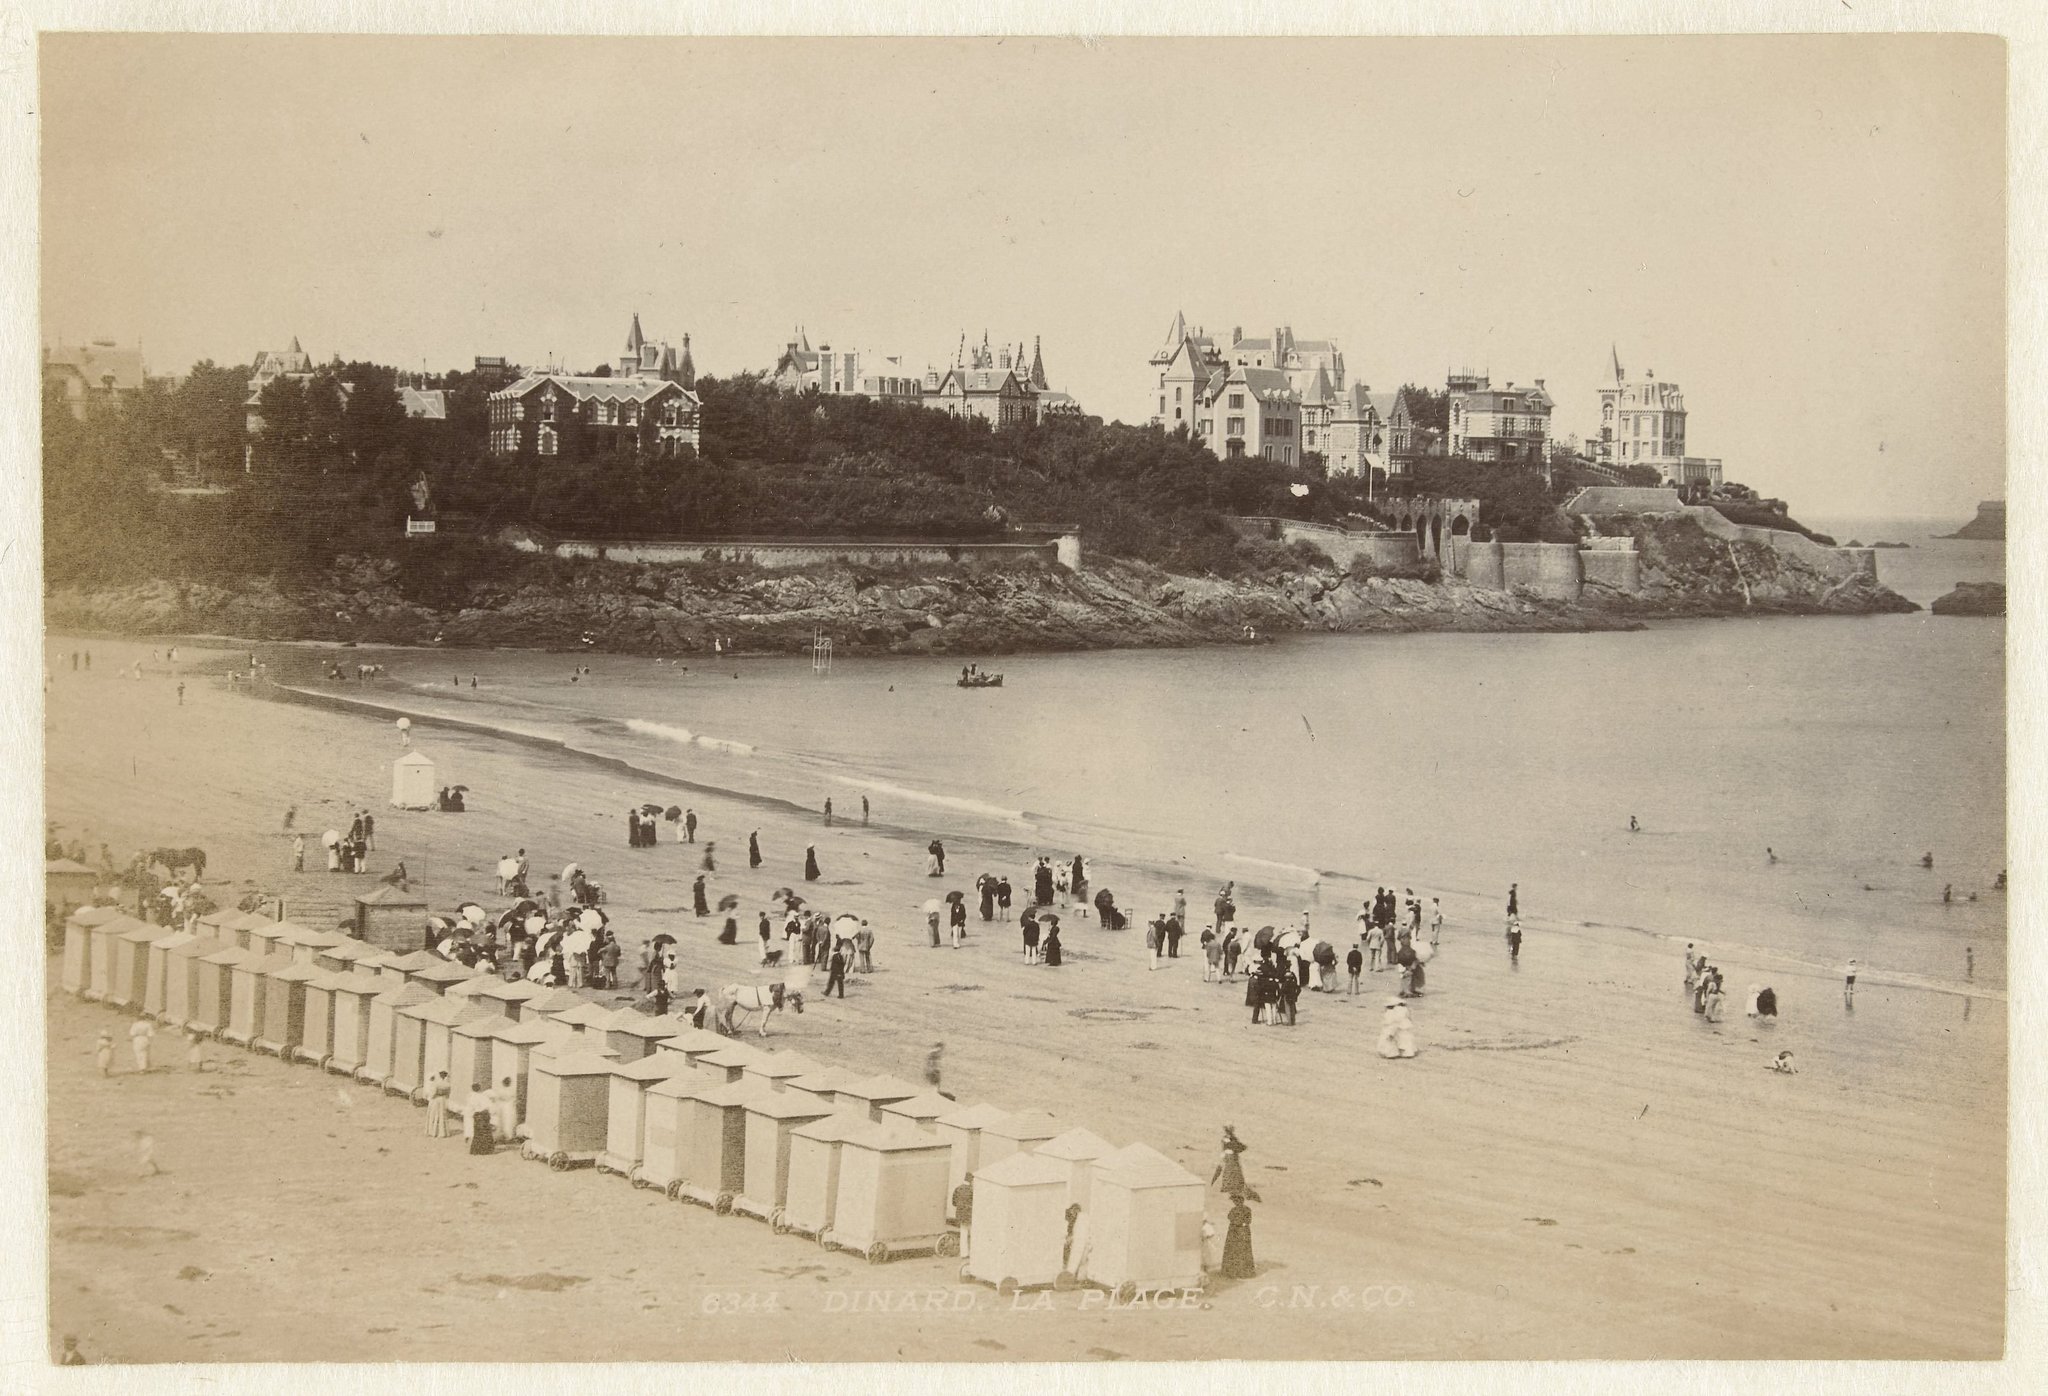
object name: photograph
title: Dinard. La plage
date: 1880-1900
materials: paper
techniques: collodion silver print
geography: dinard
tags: beach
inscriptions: inscription: ‘6344 Dinard. La plage. C.N. & Co.’